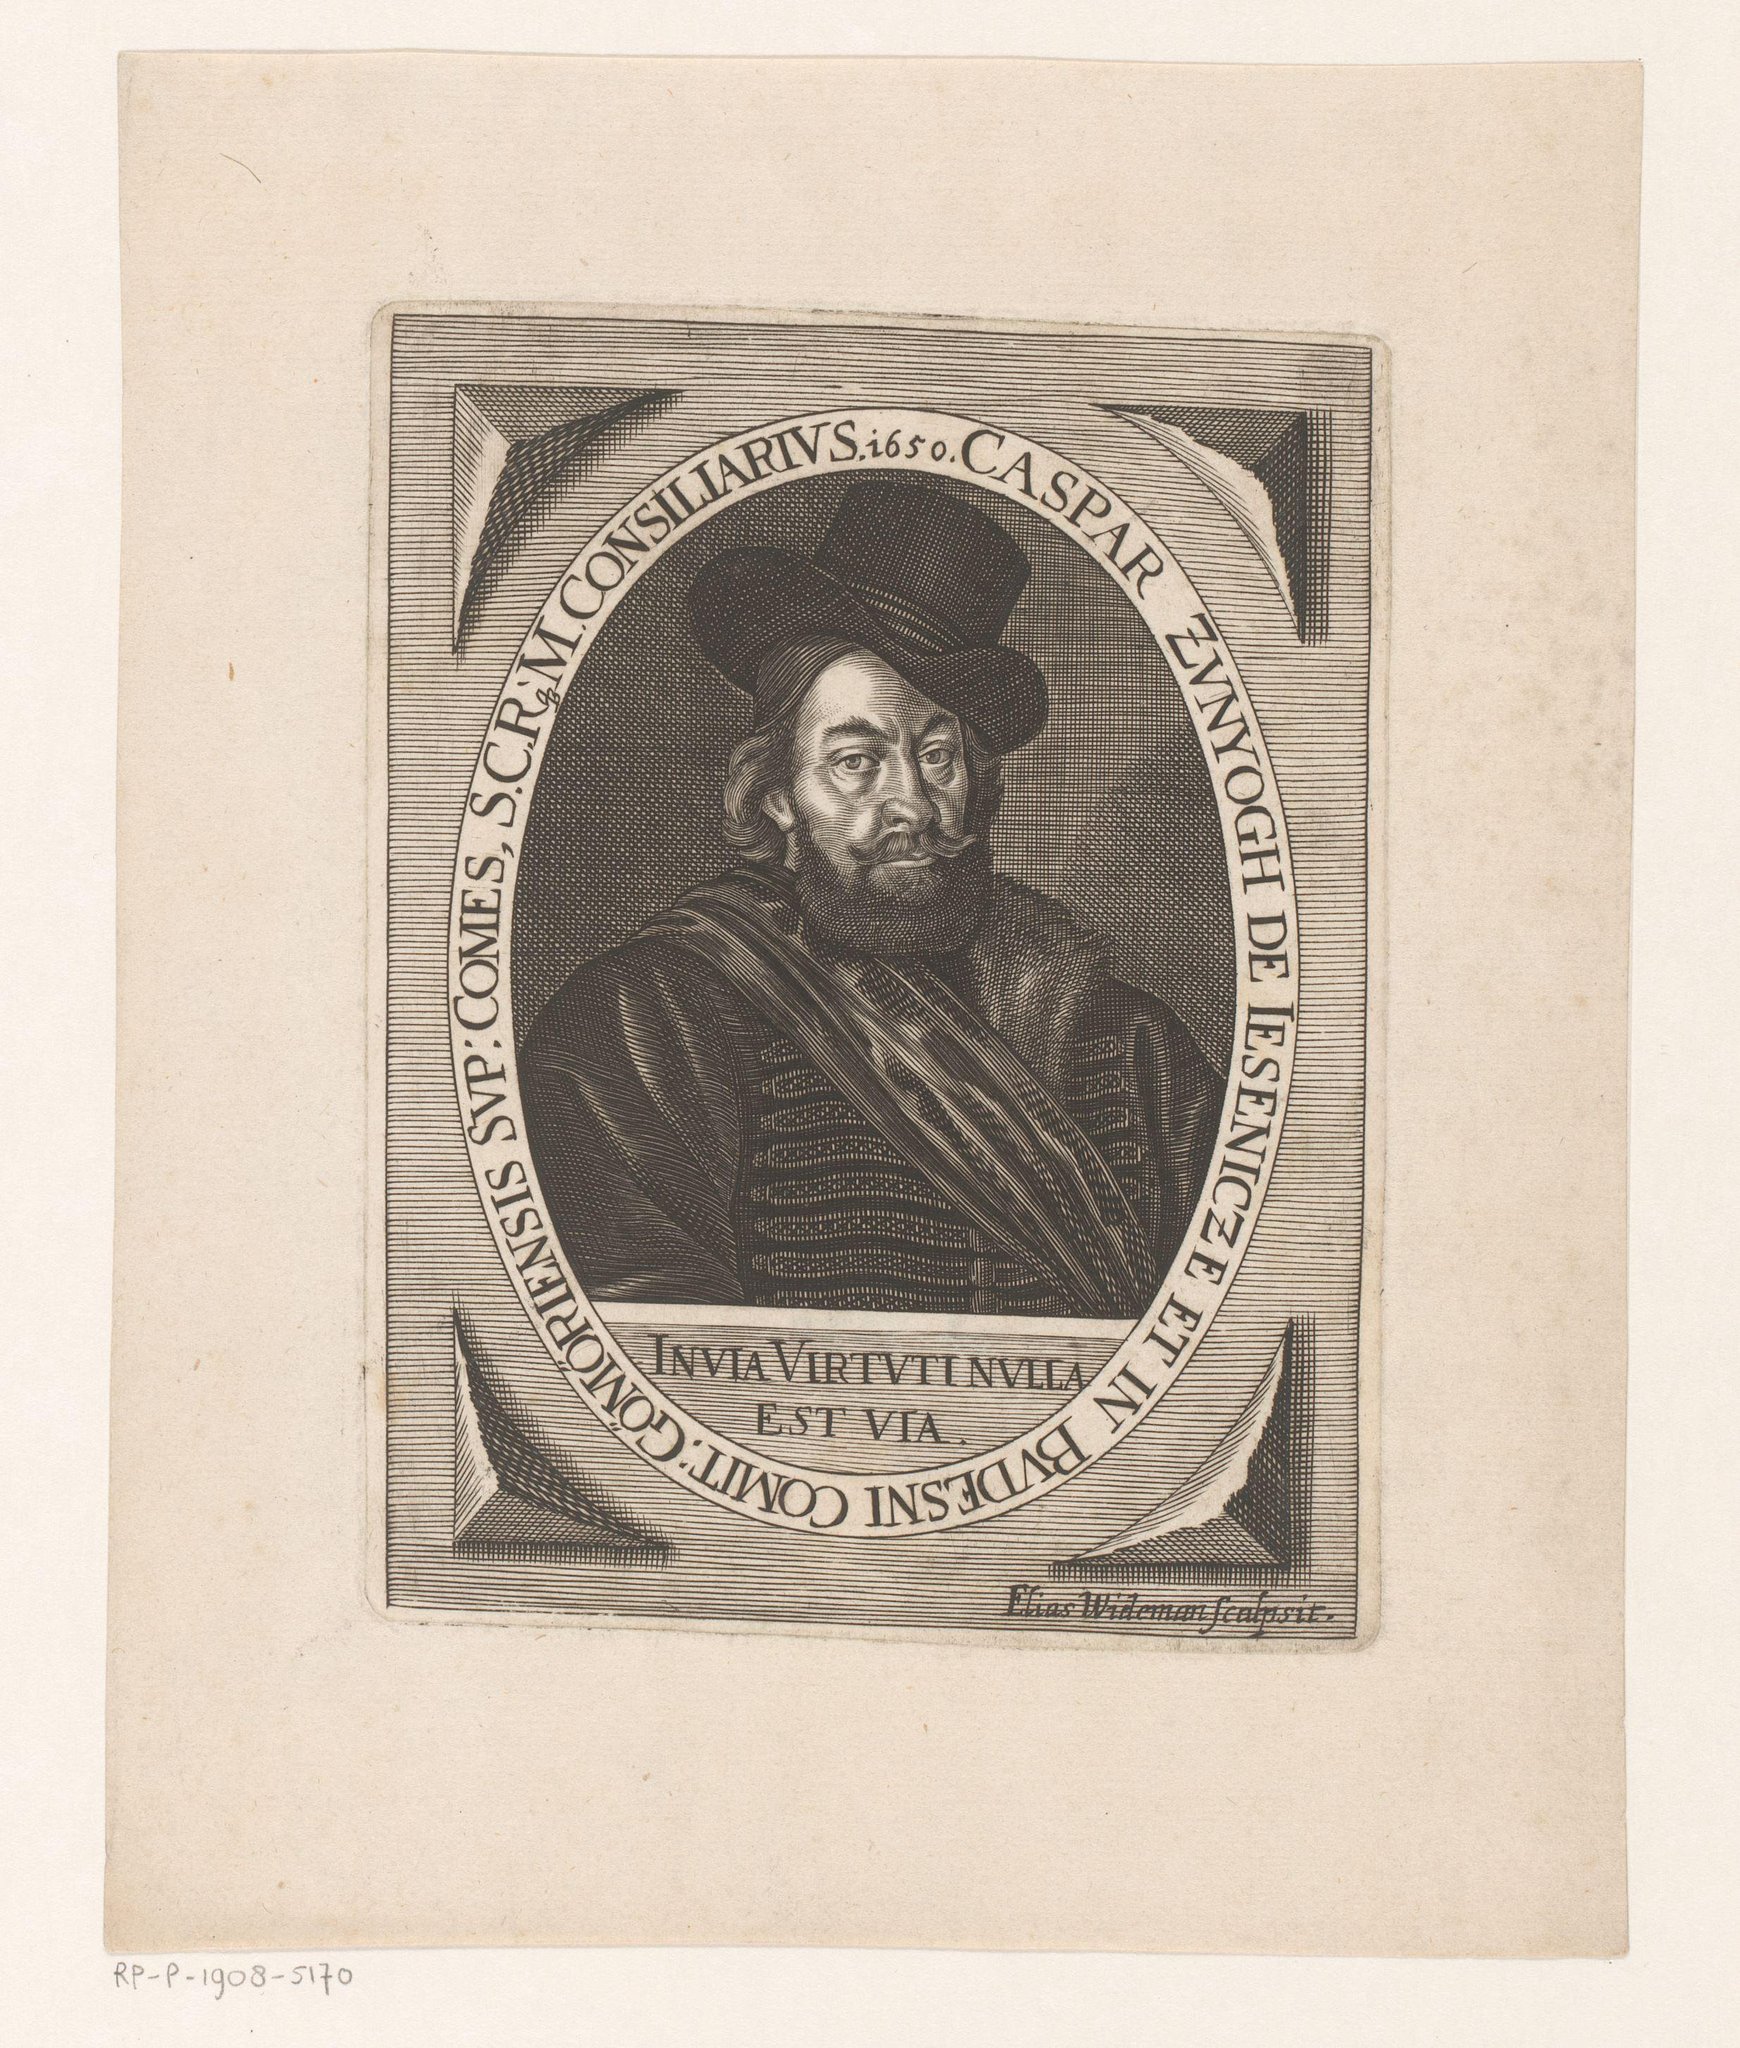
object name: print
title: Portret van Casparus Szuniogh de Jessenitze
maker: elias widemann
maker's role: print maker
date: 1650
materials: paper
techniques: engraving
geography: vienna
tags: historical persons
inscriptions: collector's mark: Lugt 2228